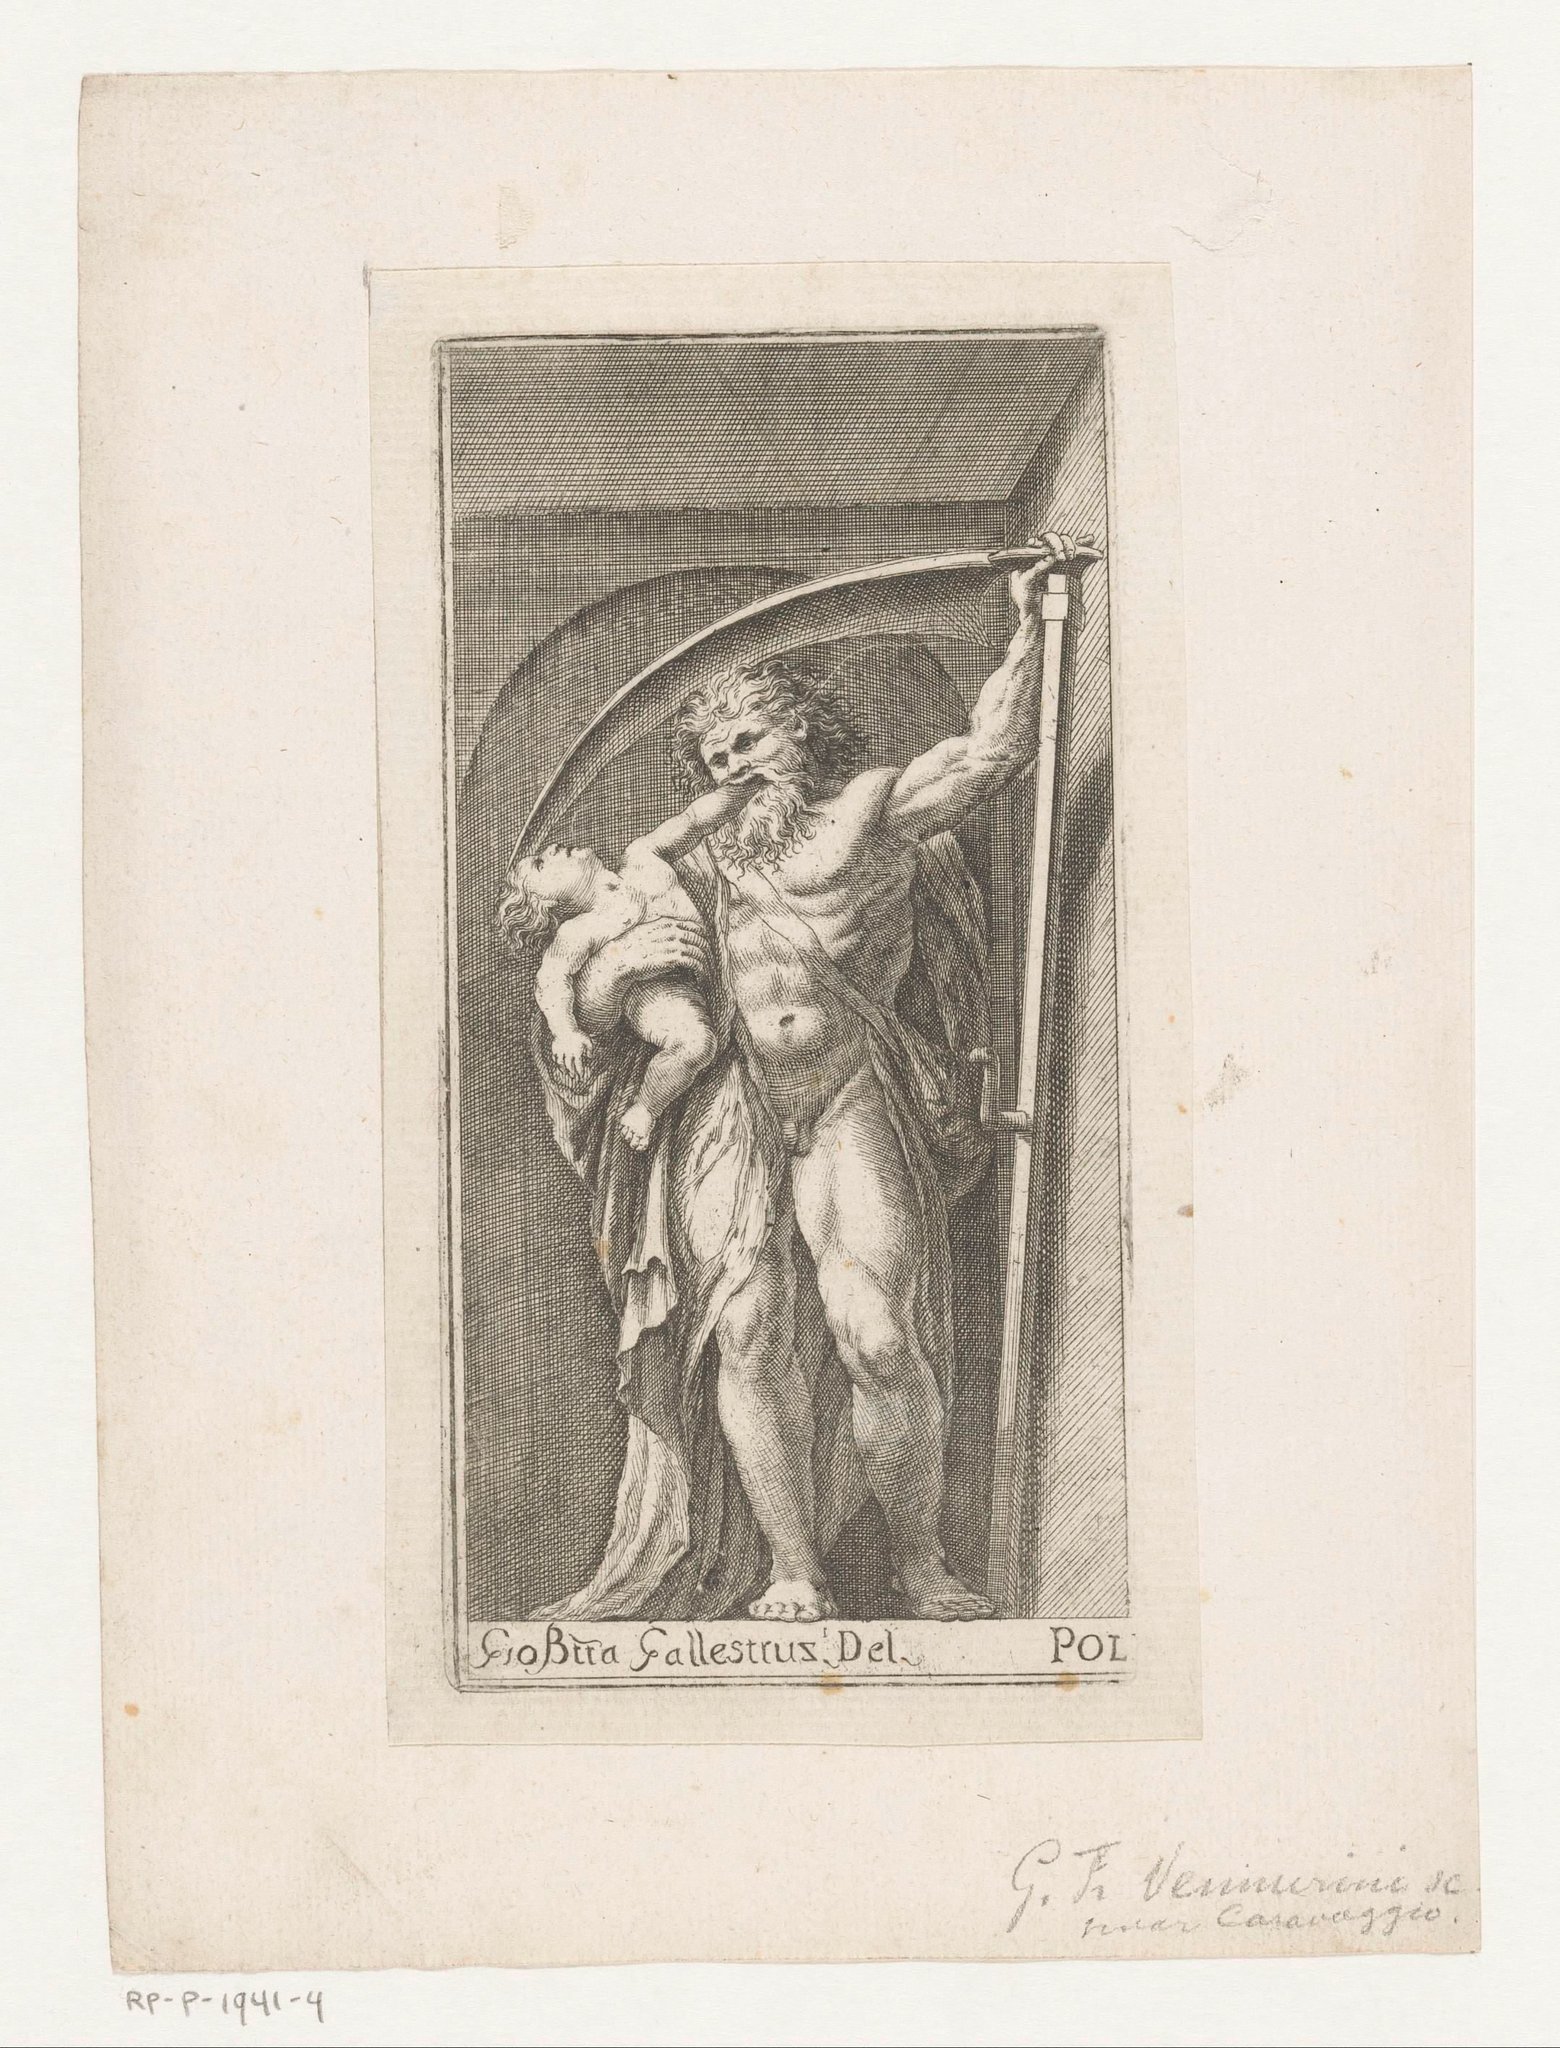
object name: print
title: Cronus verslindt een van zijn kinderen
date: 1660-1710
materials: paper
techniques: engraving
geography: italy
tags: saturn devouring his children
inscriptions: collector's mark: Lugt 2228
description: Cronus (of Saturnus) met zeis verslindt een van zijn kinderen.